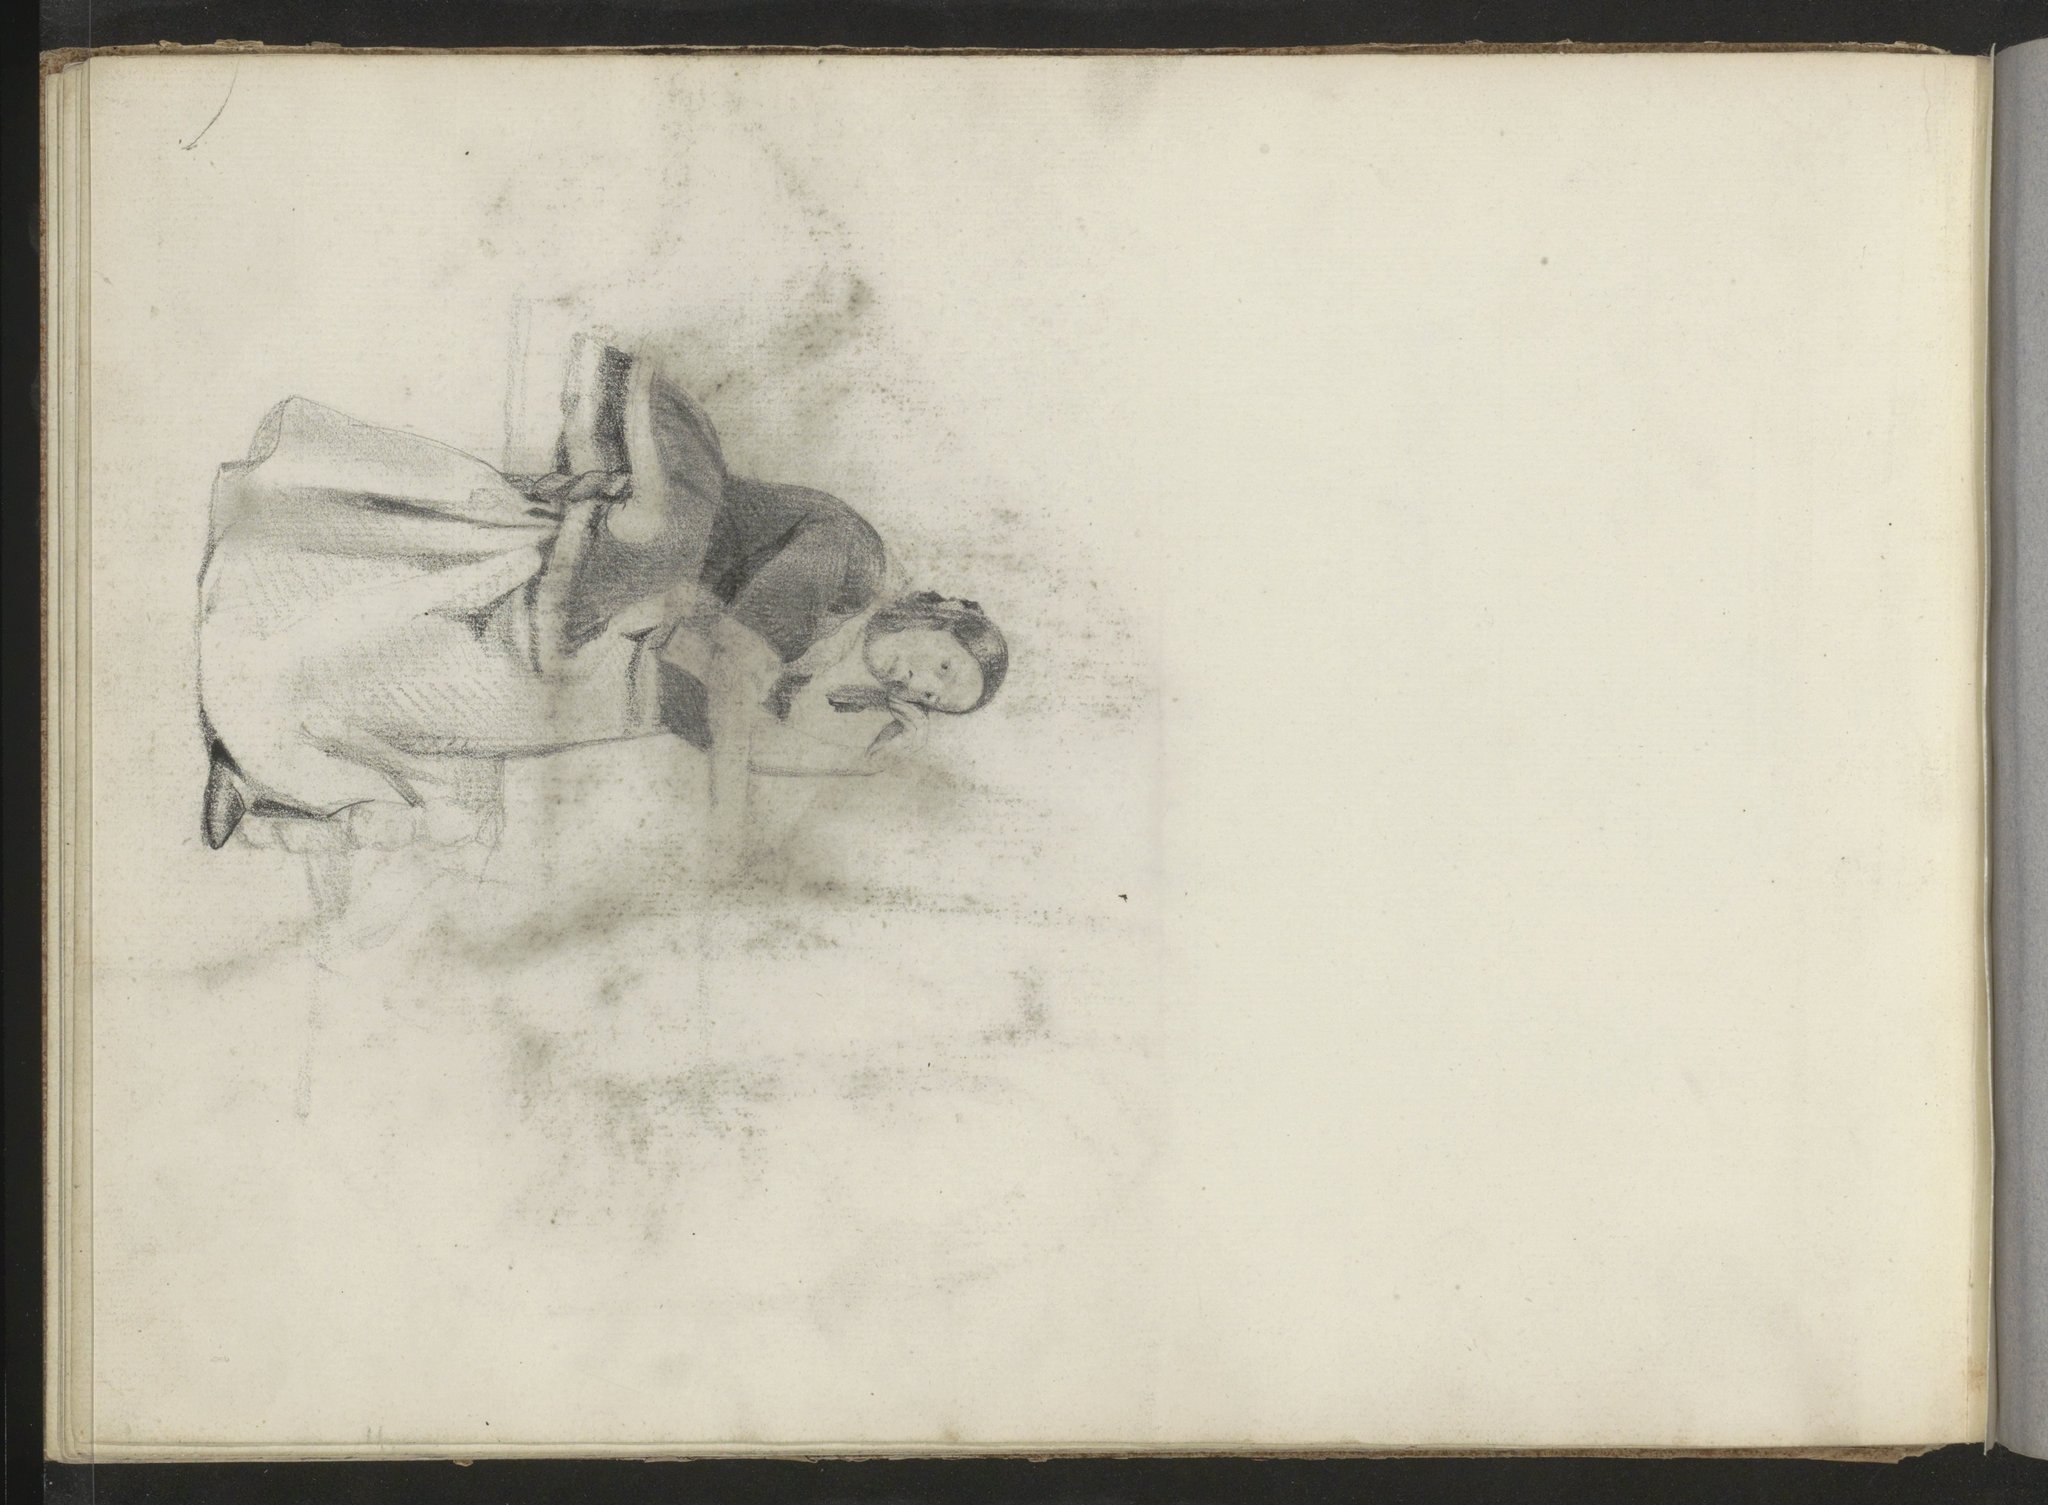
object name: sketchbook leaf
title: Zittende vrouw in een met bont afgezette jas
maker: s. altmann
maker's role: painter, print maker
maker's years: 1822-1890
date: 1803-1840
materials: paper, pencil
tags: sitting figure - aa - female human figure, housecoat (+ women's clothes)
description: De vrouw zit aan een tafel en steunt met haar hoofd op haar linkerhand. Blad 13 verso uit een schetsboek met 24 bladen.